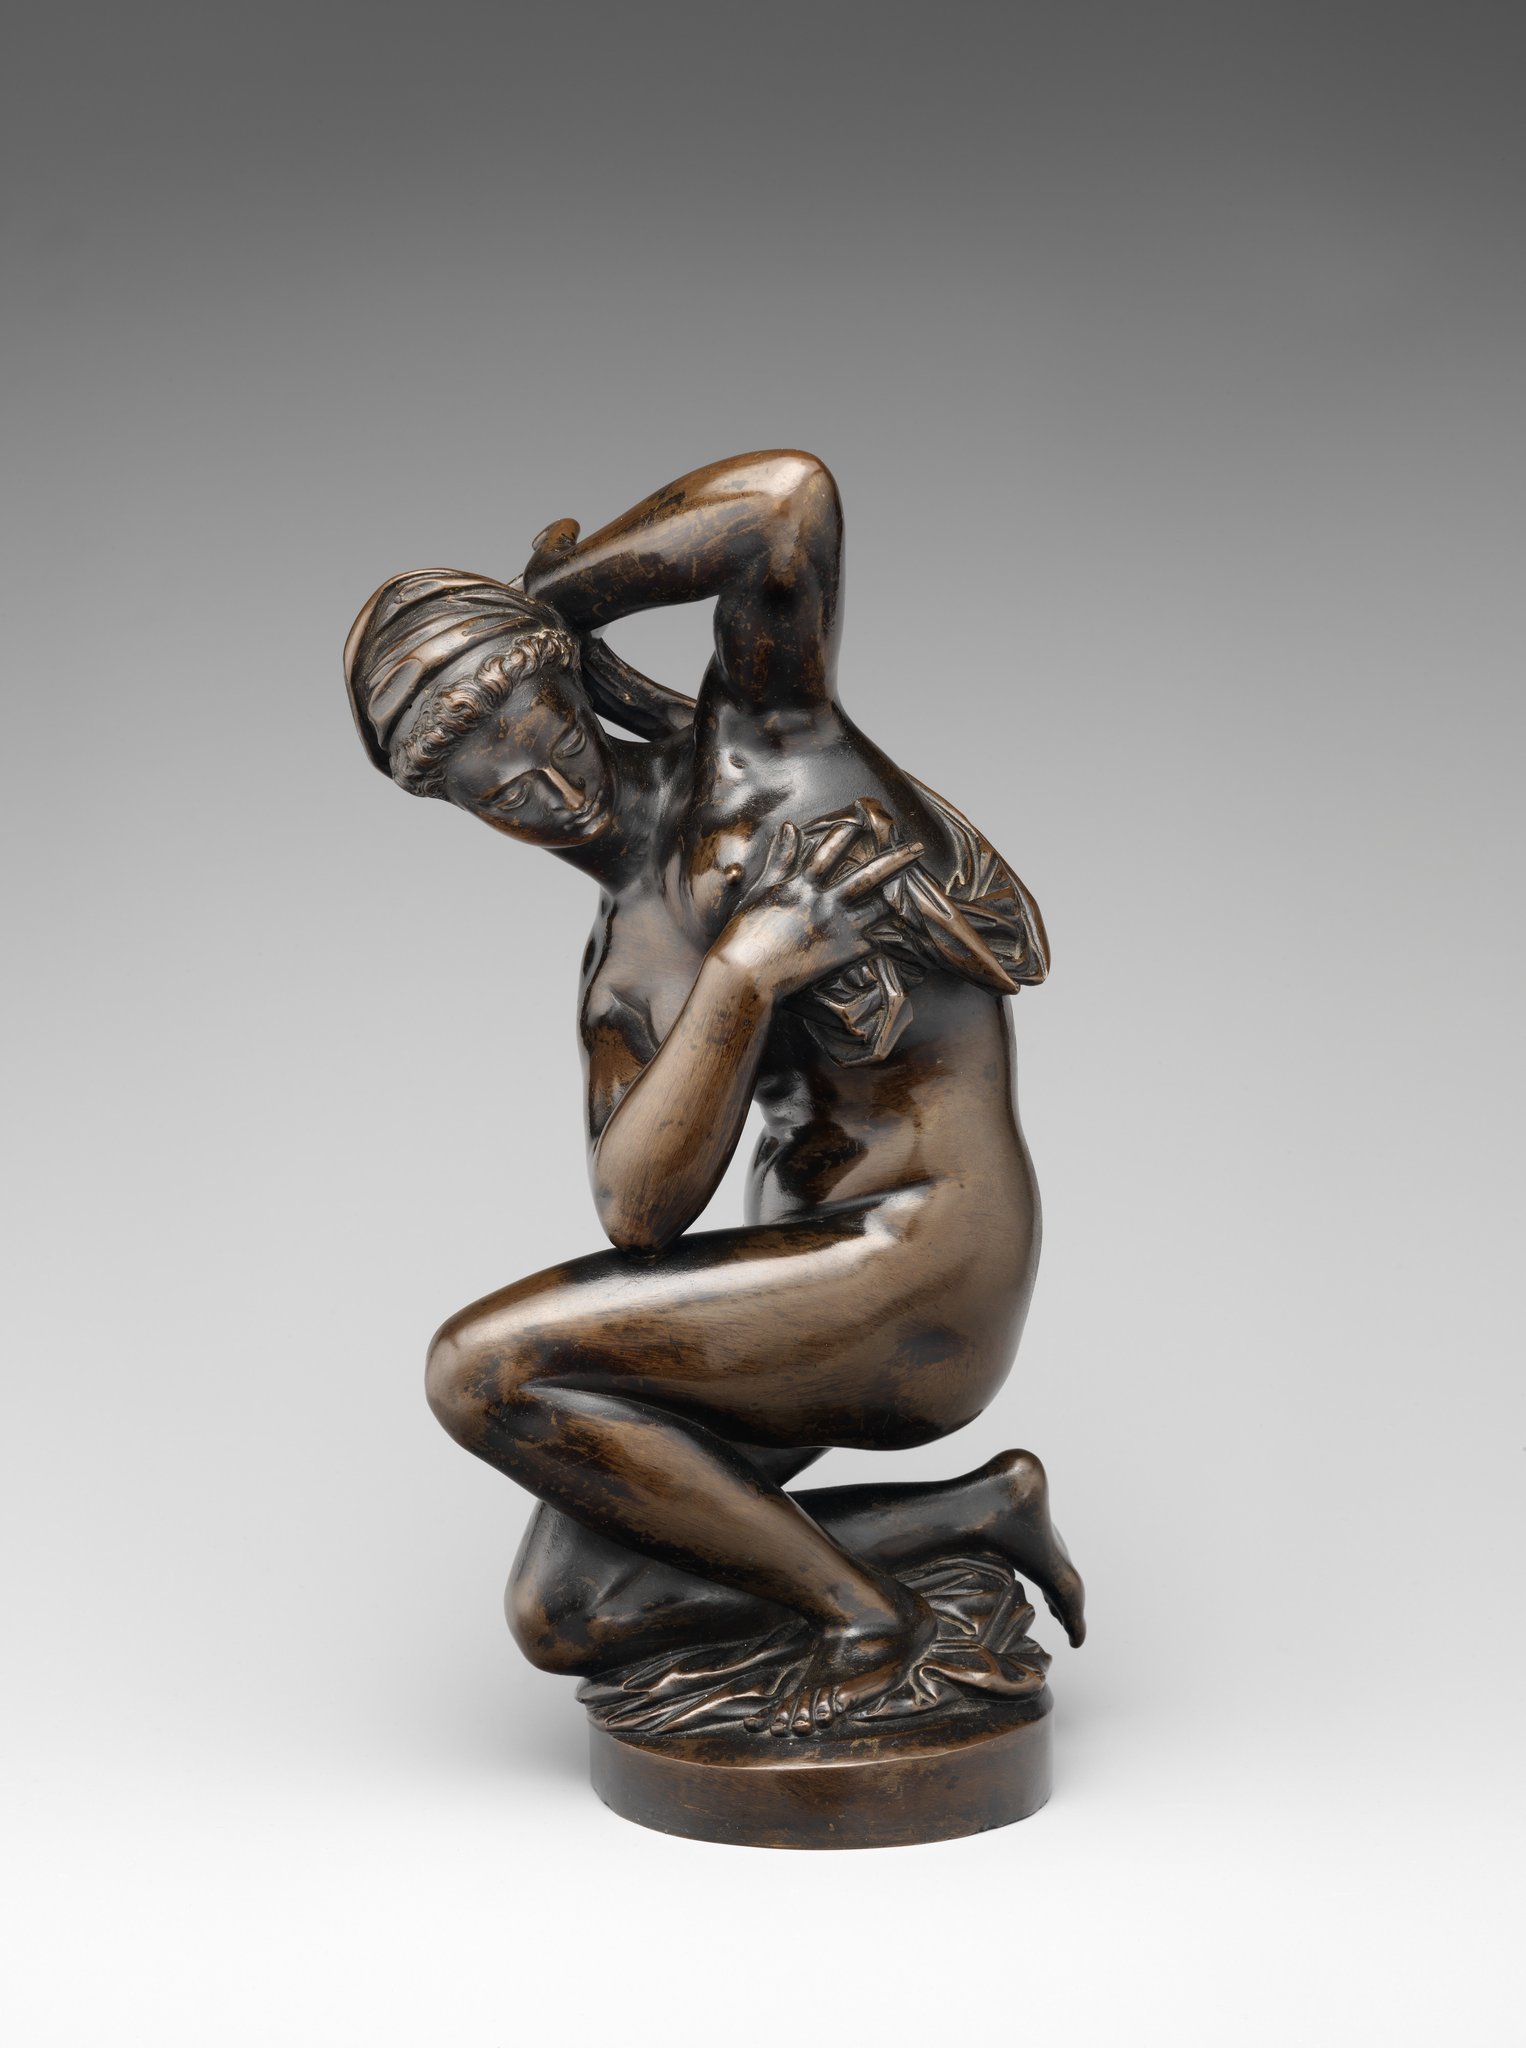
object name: statuette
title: Crouching Venus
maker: giambologna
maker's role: artist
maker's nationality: netherlandish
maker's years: 1529-1608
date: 1601-1700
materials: bronze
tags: venus